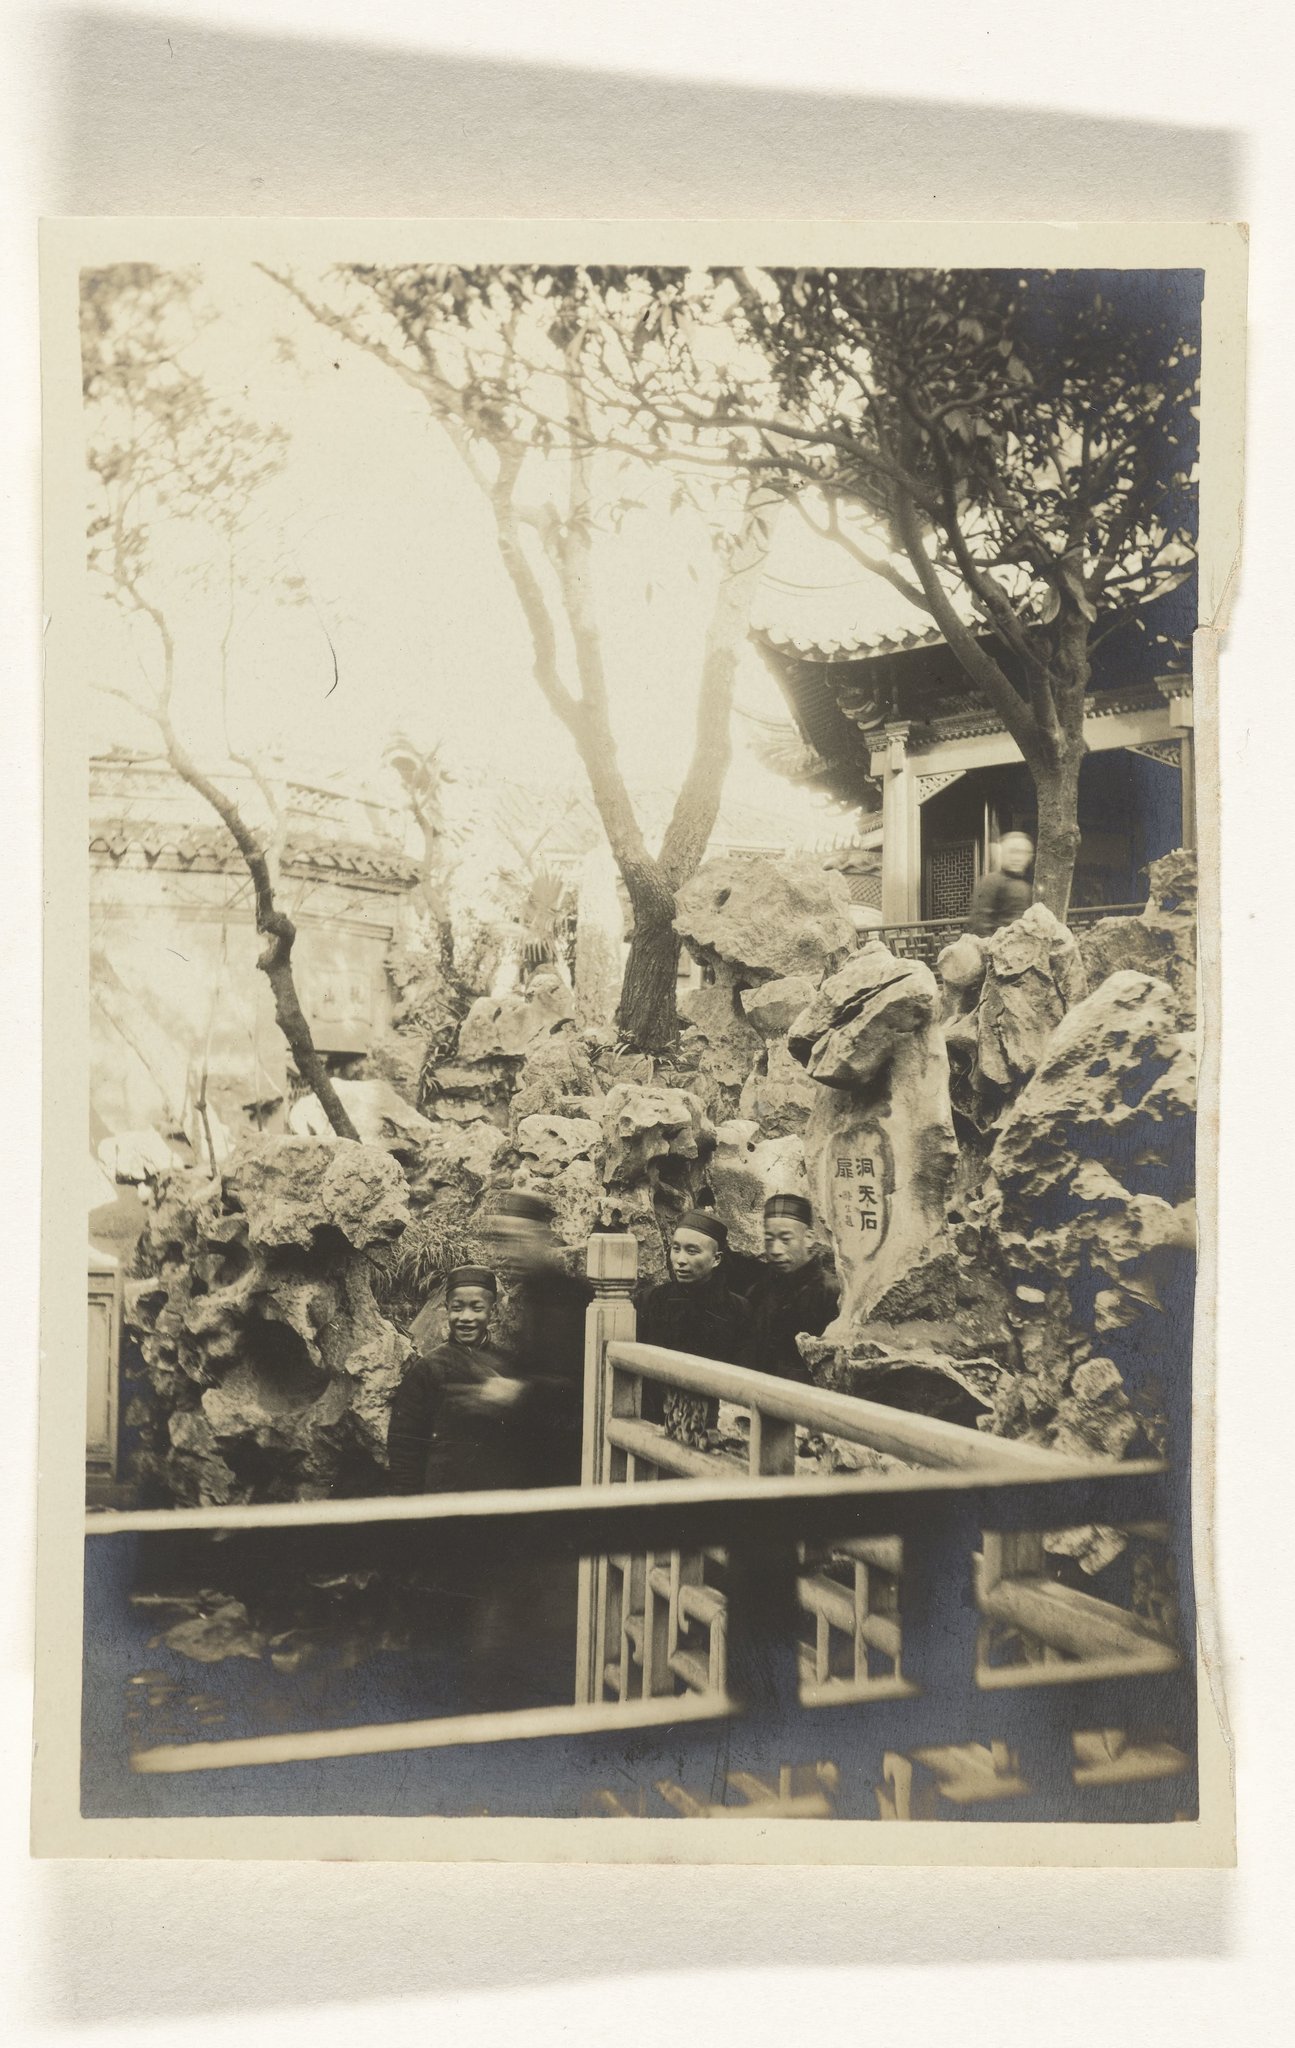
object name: photograph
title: A Chinese garden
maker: geldolph adriaan kessler (dolph)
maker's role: fotograaf, industrieel, voetballer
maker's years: 1884-1945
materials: cardboard, photographic support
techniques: gelatin silver print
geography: shanghai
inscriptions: title: ‘A Chinese garden’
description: Chinese mannen in traditionele kleding in een rotstuin. Op de achtergrond is een chinese woning met uitlopend dak zichtbaar. Onderdeel van het fotoalbum van Dolph Kessler met opnamen die hij maakte tijdens zijn verblijf in Engeland en op een wereldreis die hij als secretaris van Henri Deterding (directeur Koninklijke Olie) ondernam naar Nederlands-Indië, Japan, China en de Verenigde Staten, tussen 1906 en 1908.